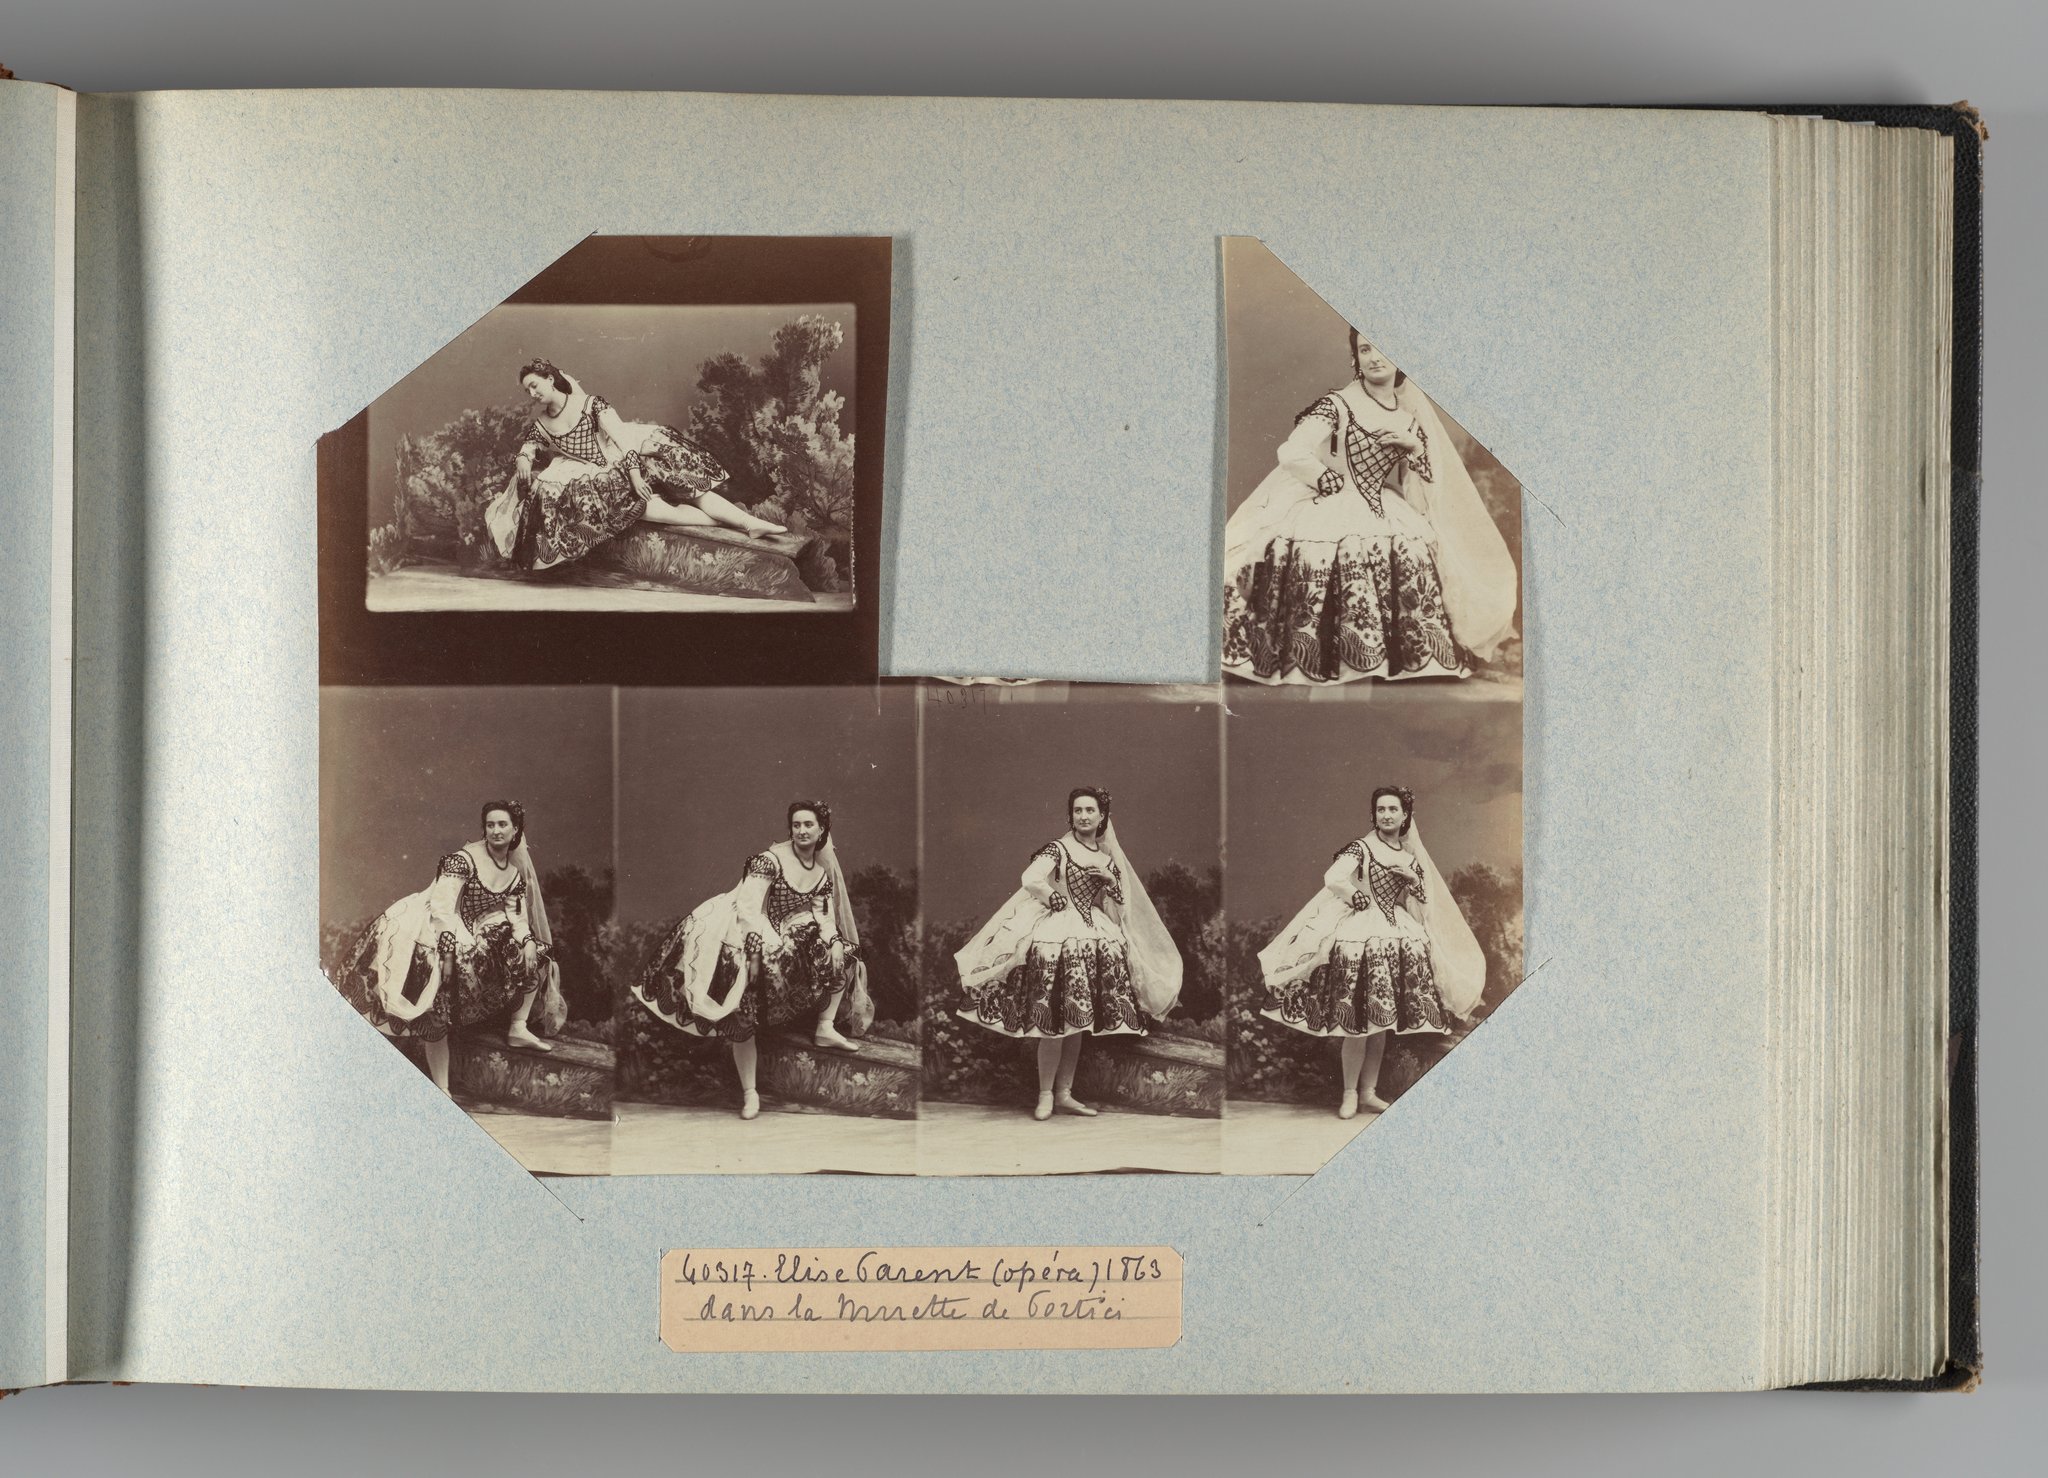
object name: photograph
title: Elise Parent (opéra) 1863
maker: andré-adolphe-eugène disdéri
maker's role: artist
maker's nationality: french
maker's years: 1819-1889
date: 1863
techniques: albumen silver print, glass negative